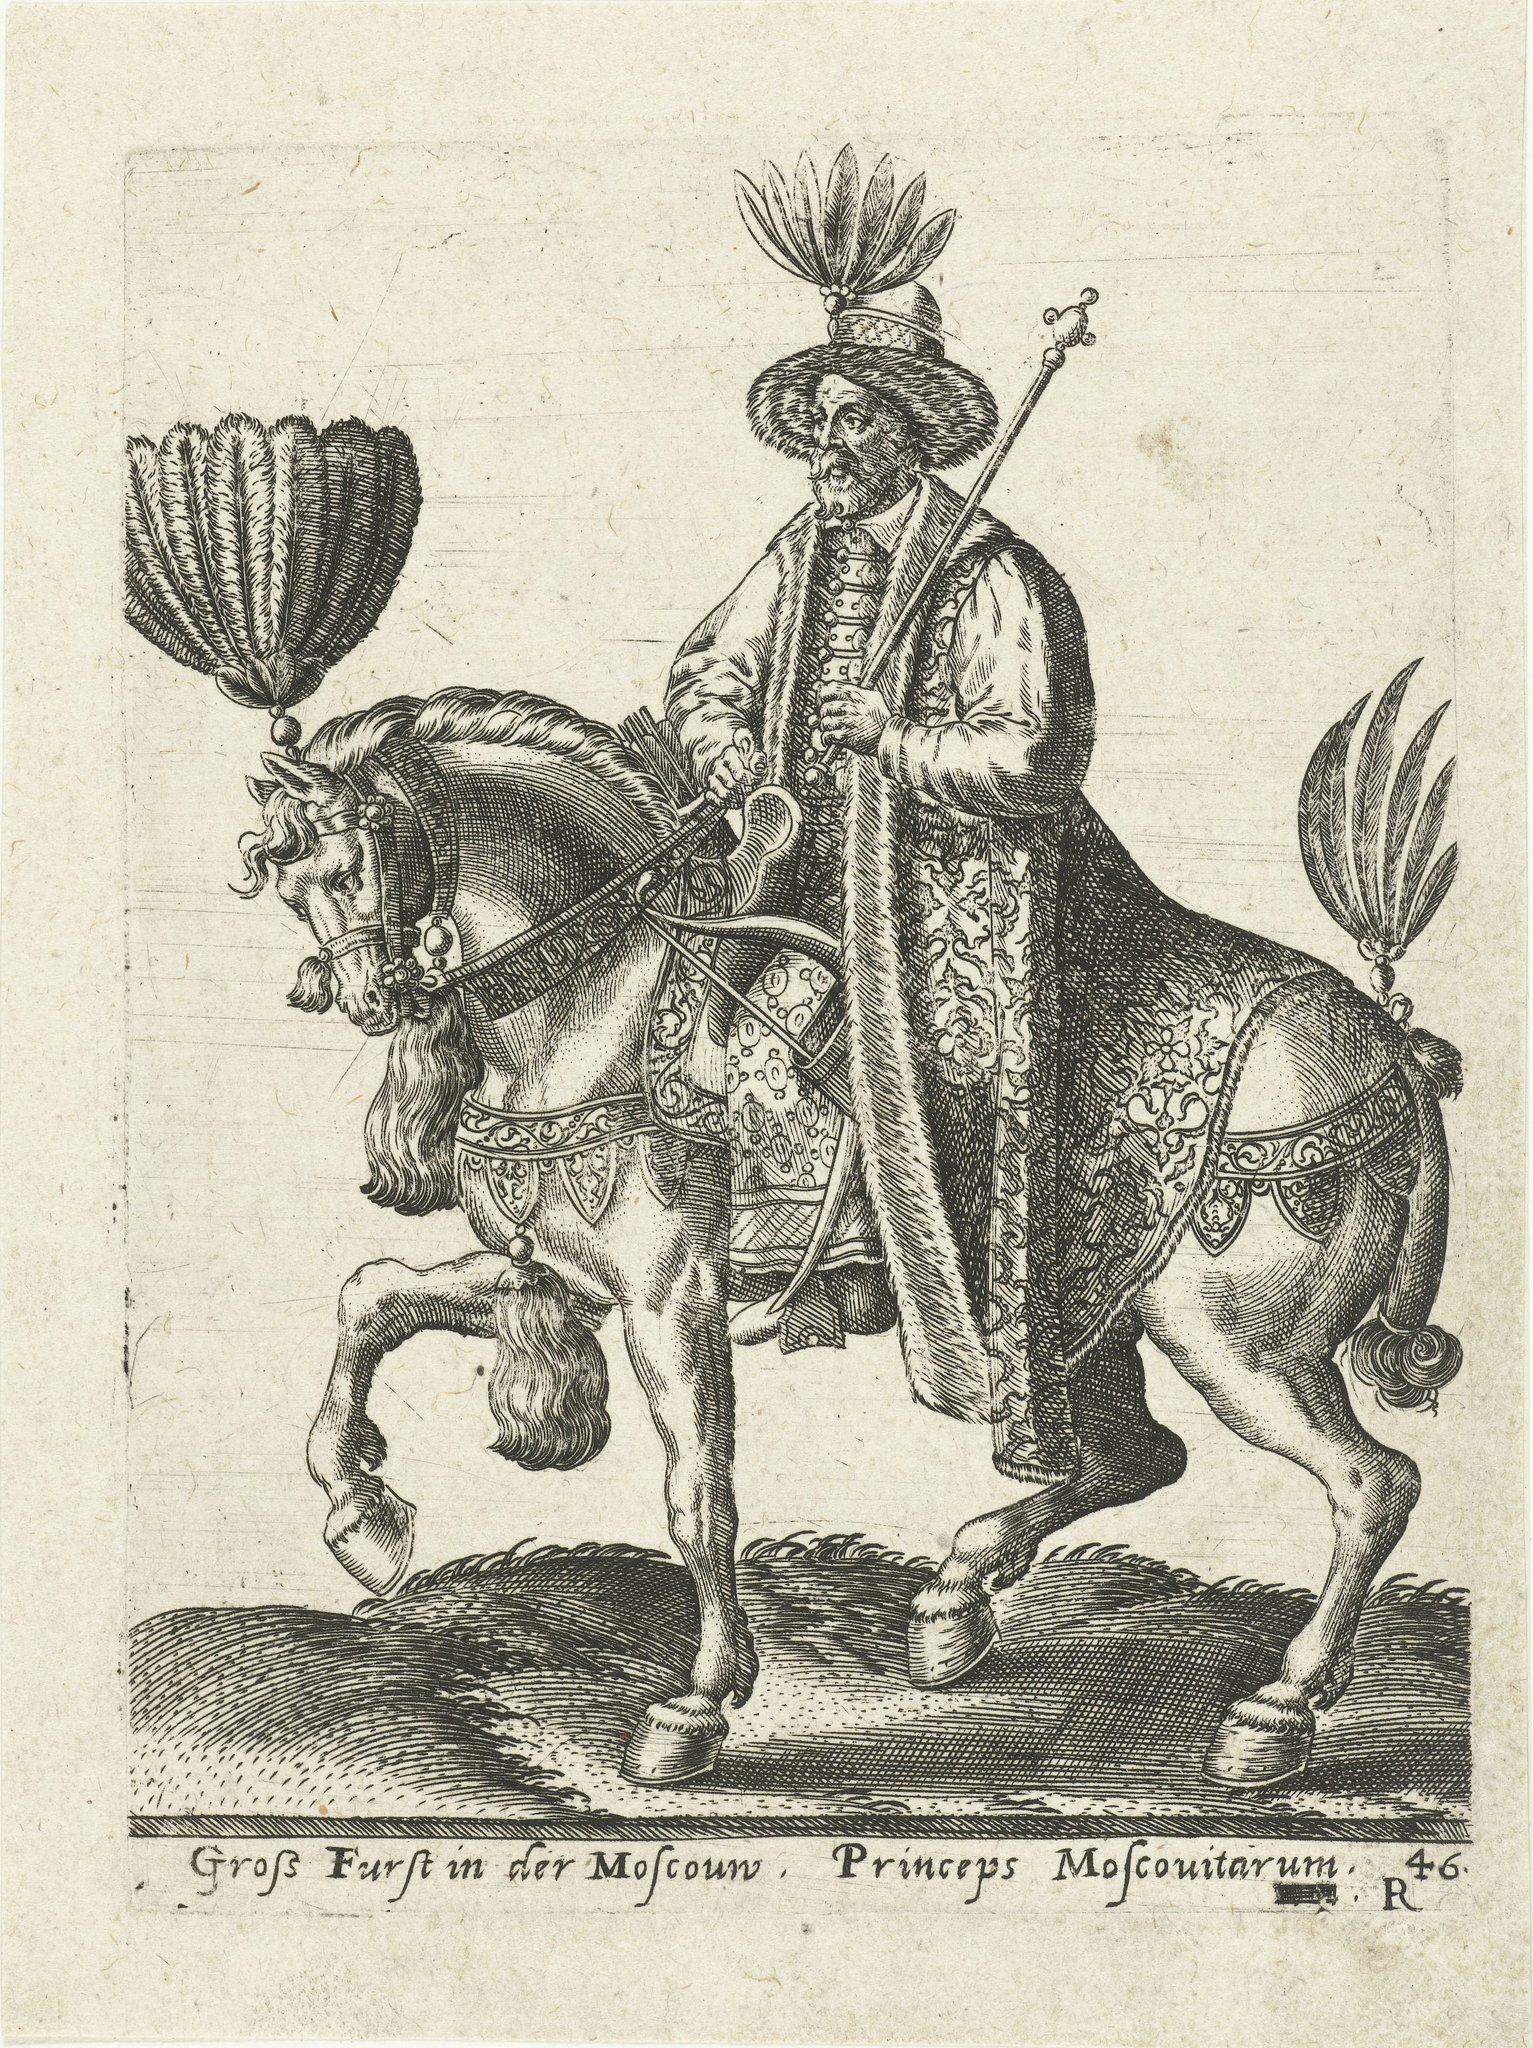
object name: costume print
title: Grootvorst van Moskou te paard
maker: abraham de bruyn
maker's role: print maker, publisher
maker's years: 1540-1587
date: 1577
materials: paper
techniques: engraving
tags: sceptre, staff (symbol of sovereignty), warfare; military affairs (+ cavalry, horsemen), emperor, folk costume, regional costume, europeans (with name)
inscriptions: collector's mark: Lugt 2228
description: Paard en ruiter naar links. Het paard is in stap. De ruiter is koninklijk gekleed naar Russische mode. Hij draagt een scepter. De prent heeft een Duits en Latijns onderschrift. Prent oorspronkelijk uit 'Equitum descripcio...', 1577.